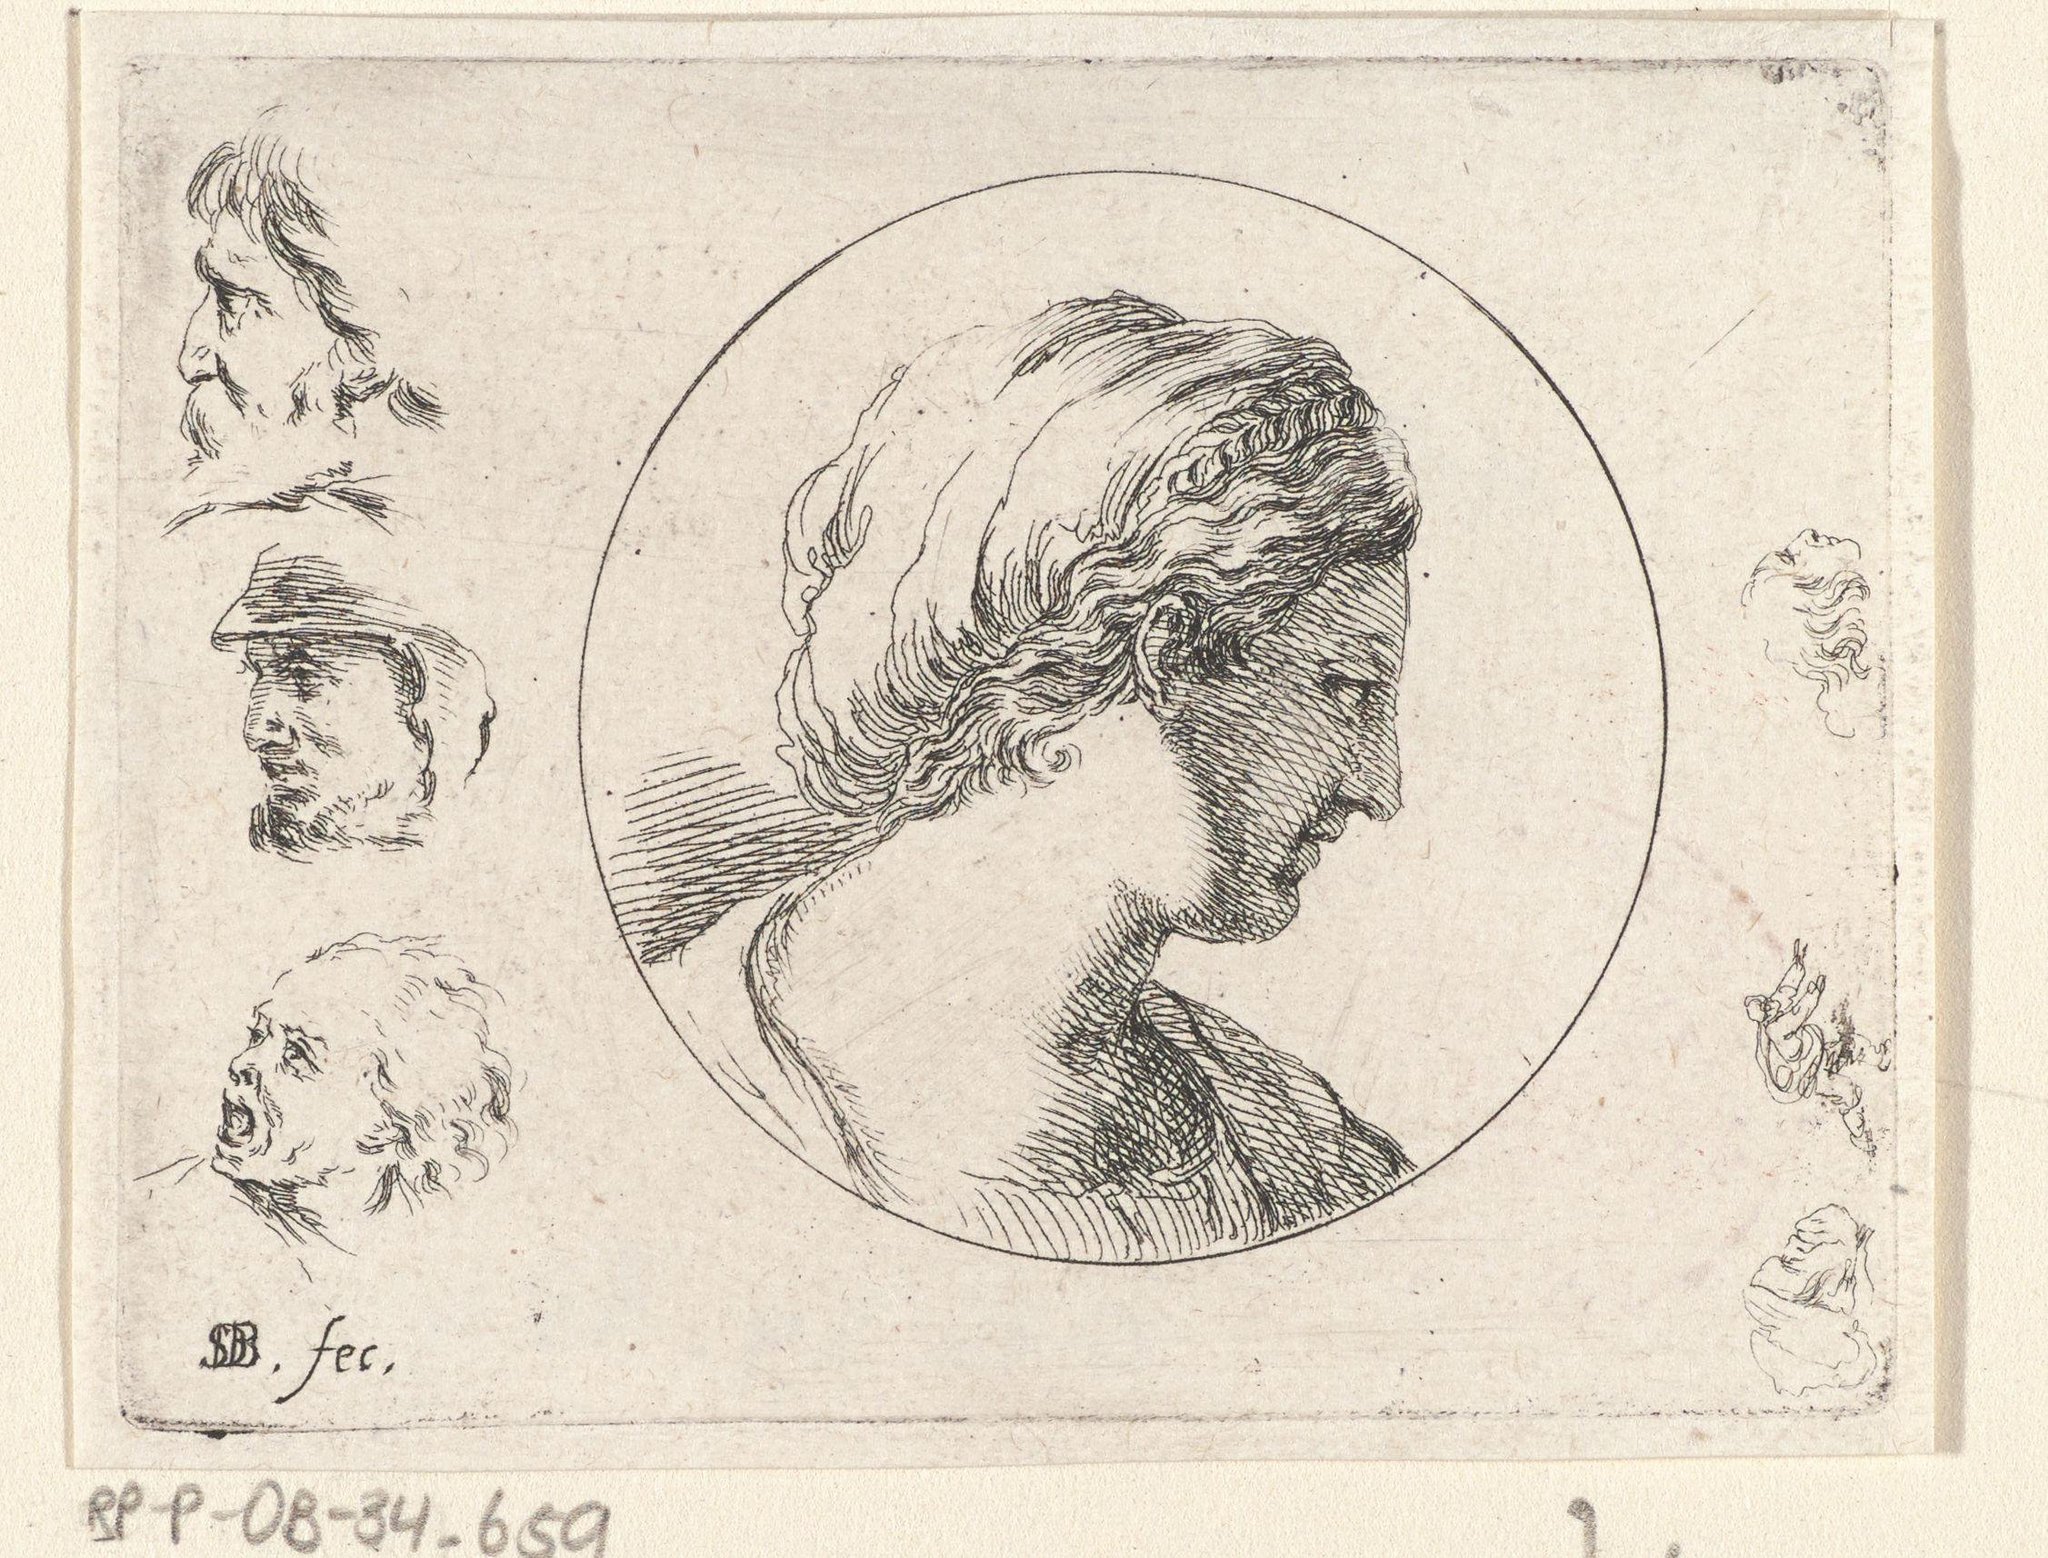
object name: print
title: Recueil de divers griffonnemens et preuves d'eau forte [deel 2]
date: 1620-1664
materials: paper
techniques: etching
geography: france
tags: adult woman, adult man, old man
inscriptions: collector's mark: Lugt 240